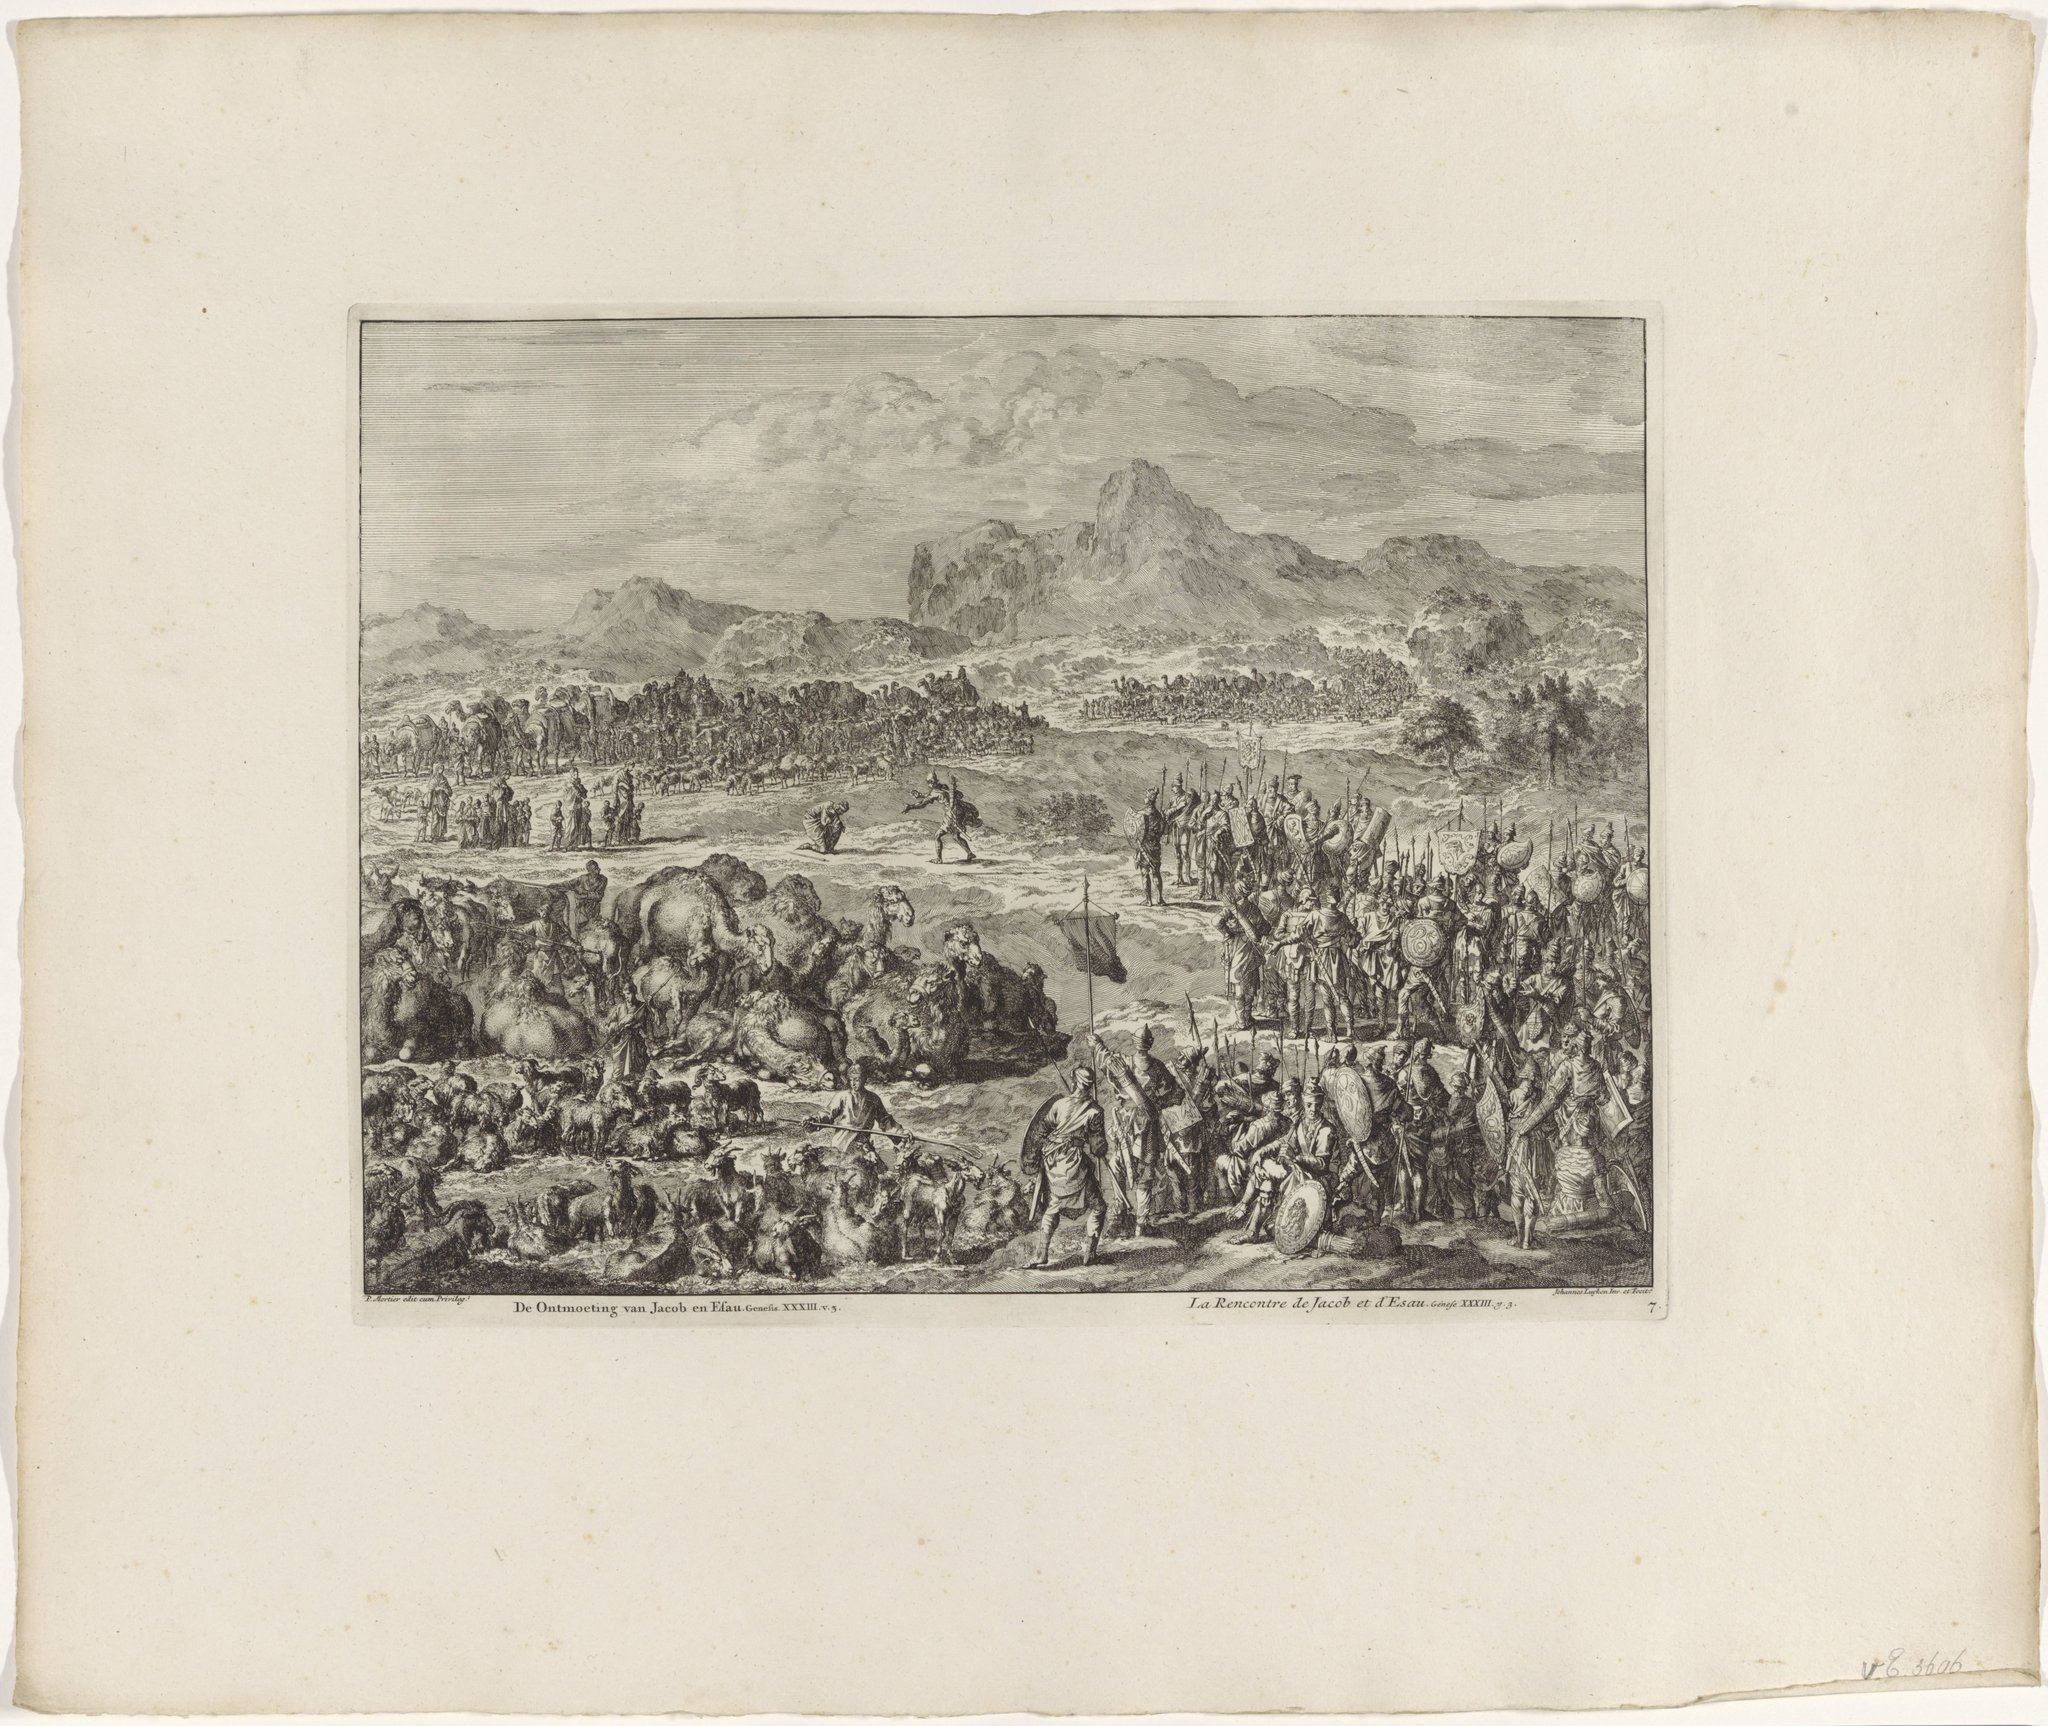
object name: print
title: De Ontmoeting van Jacob en Esau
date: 1708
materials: paper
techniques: etching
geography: amsterdam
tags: the meeting between esau and jacob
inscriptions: collector's mark: Lugt 2228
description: De ontmoeting van Jakob en Esau met hun families en gevolg. Jakob knielt voor zijn broer Esau, die hem overeind helpt.